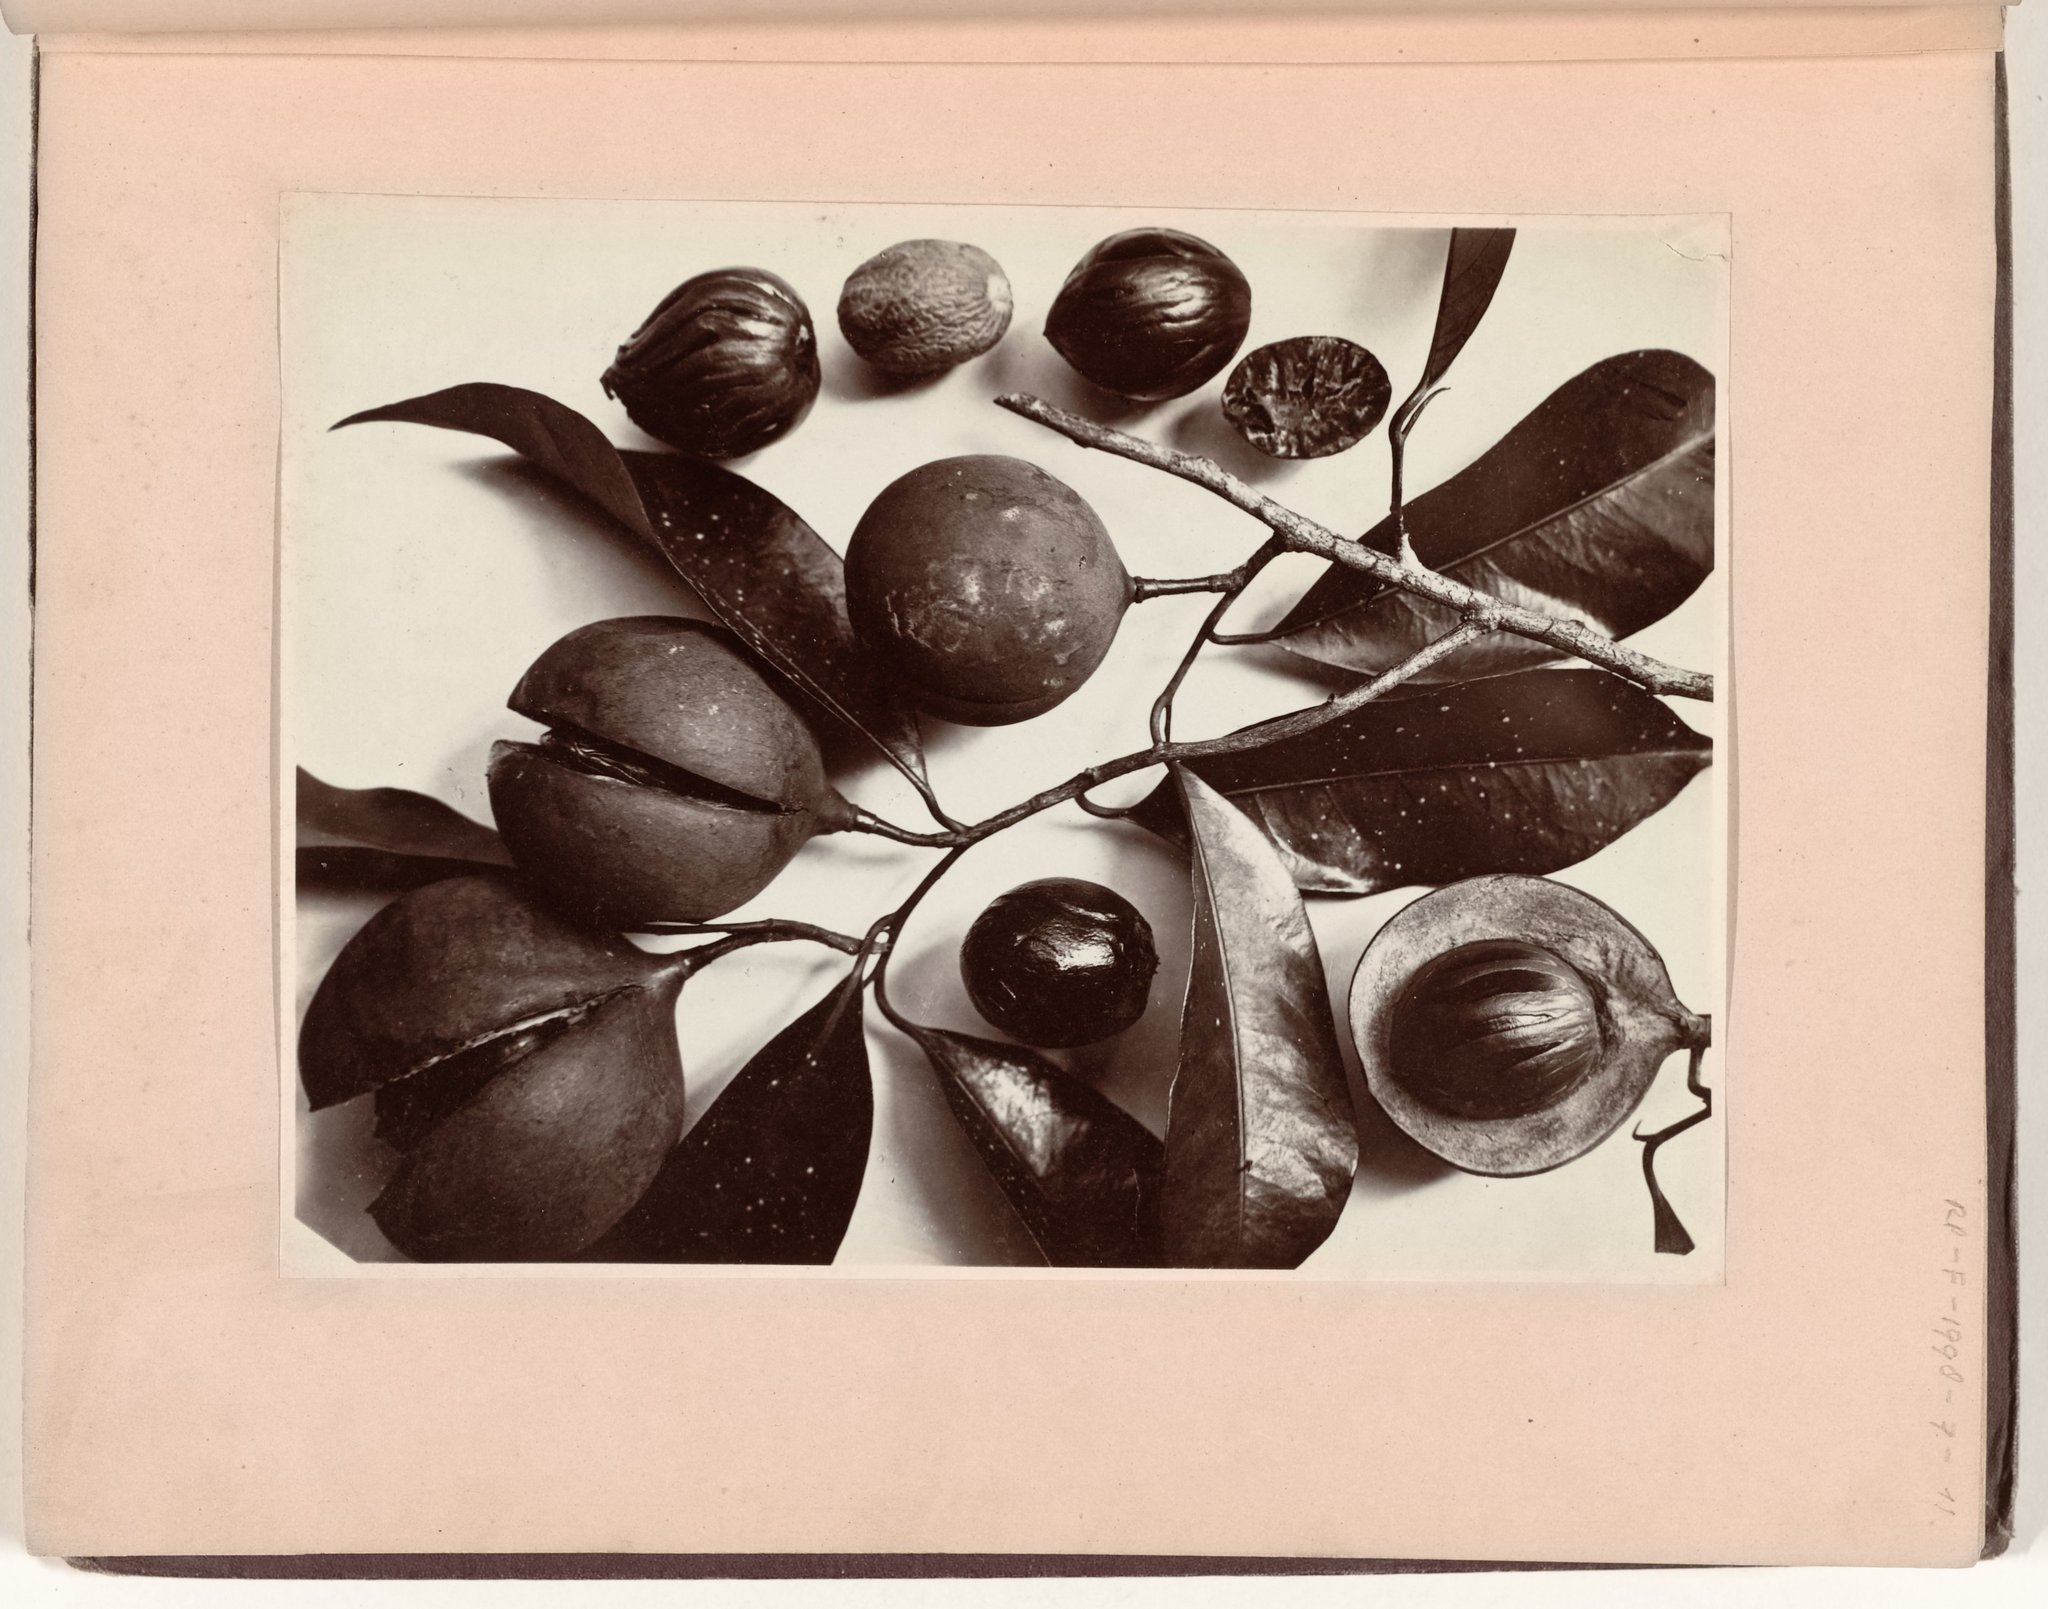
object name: album leaf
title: Nootmuskaat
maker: c. dietrich (fotograaf)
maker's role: fotograaf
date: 1875-1890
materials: cardboard, paper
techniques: albumen print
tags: fruits: nuts, indonesia